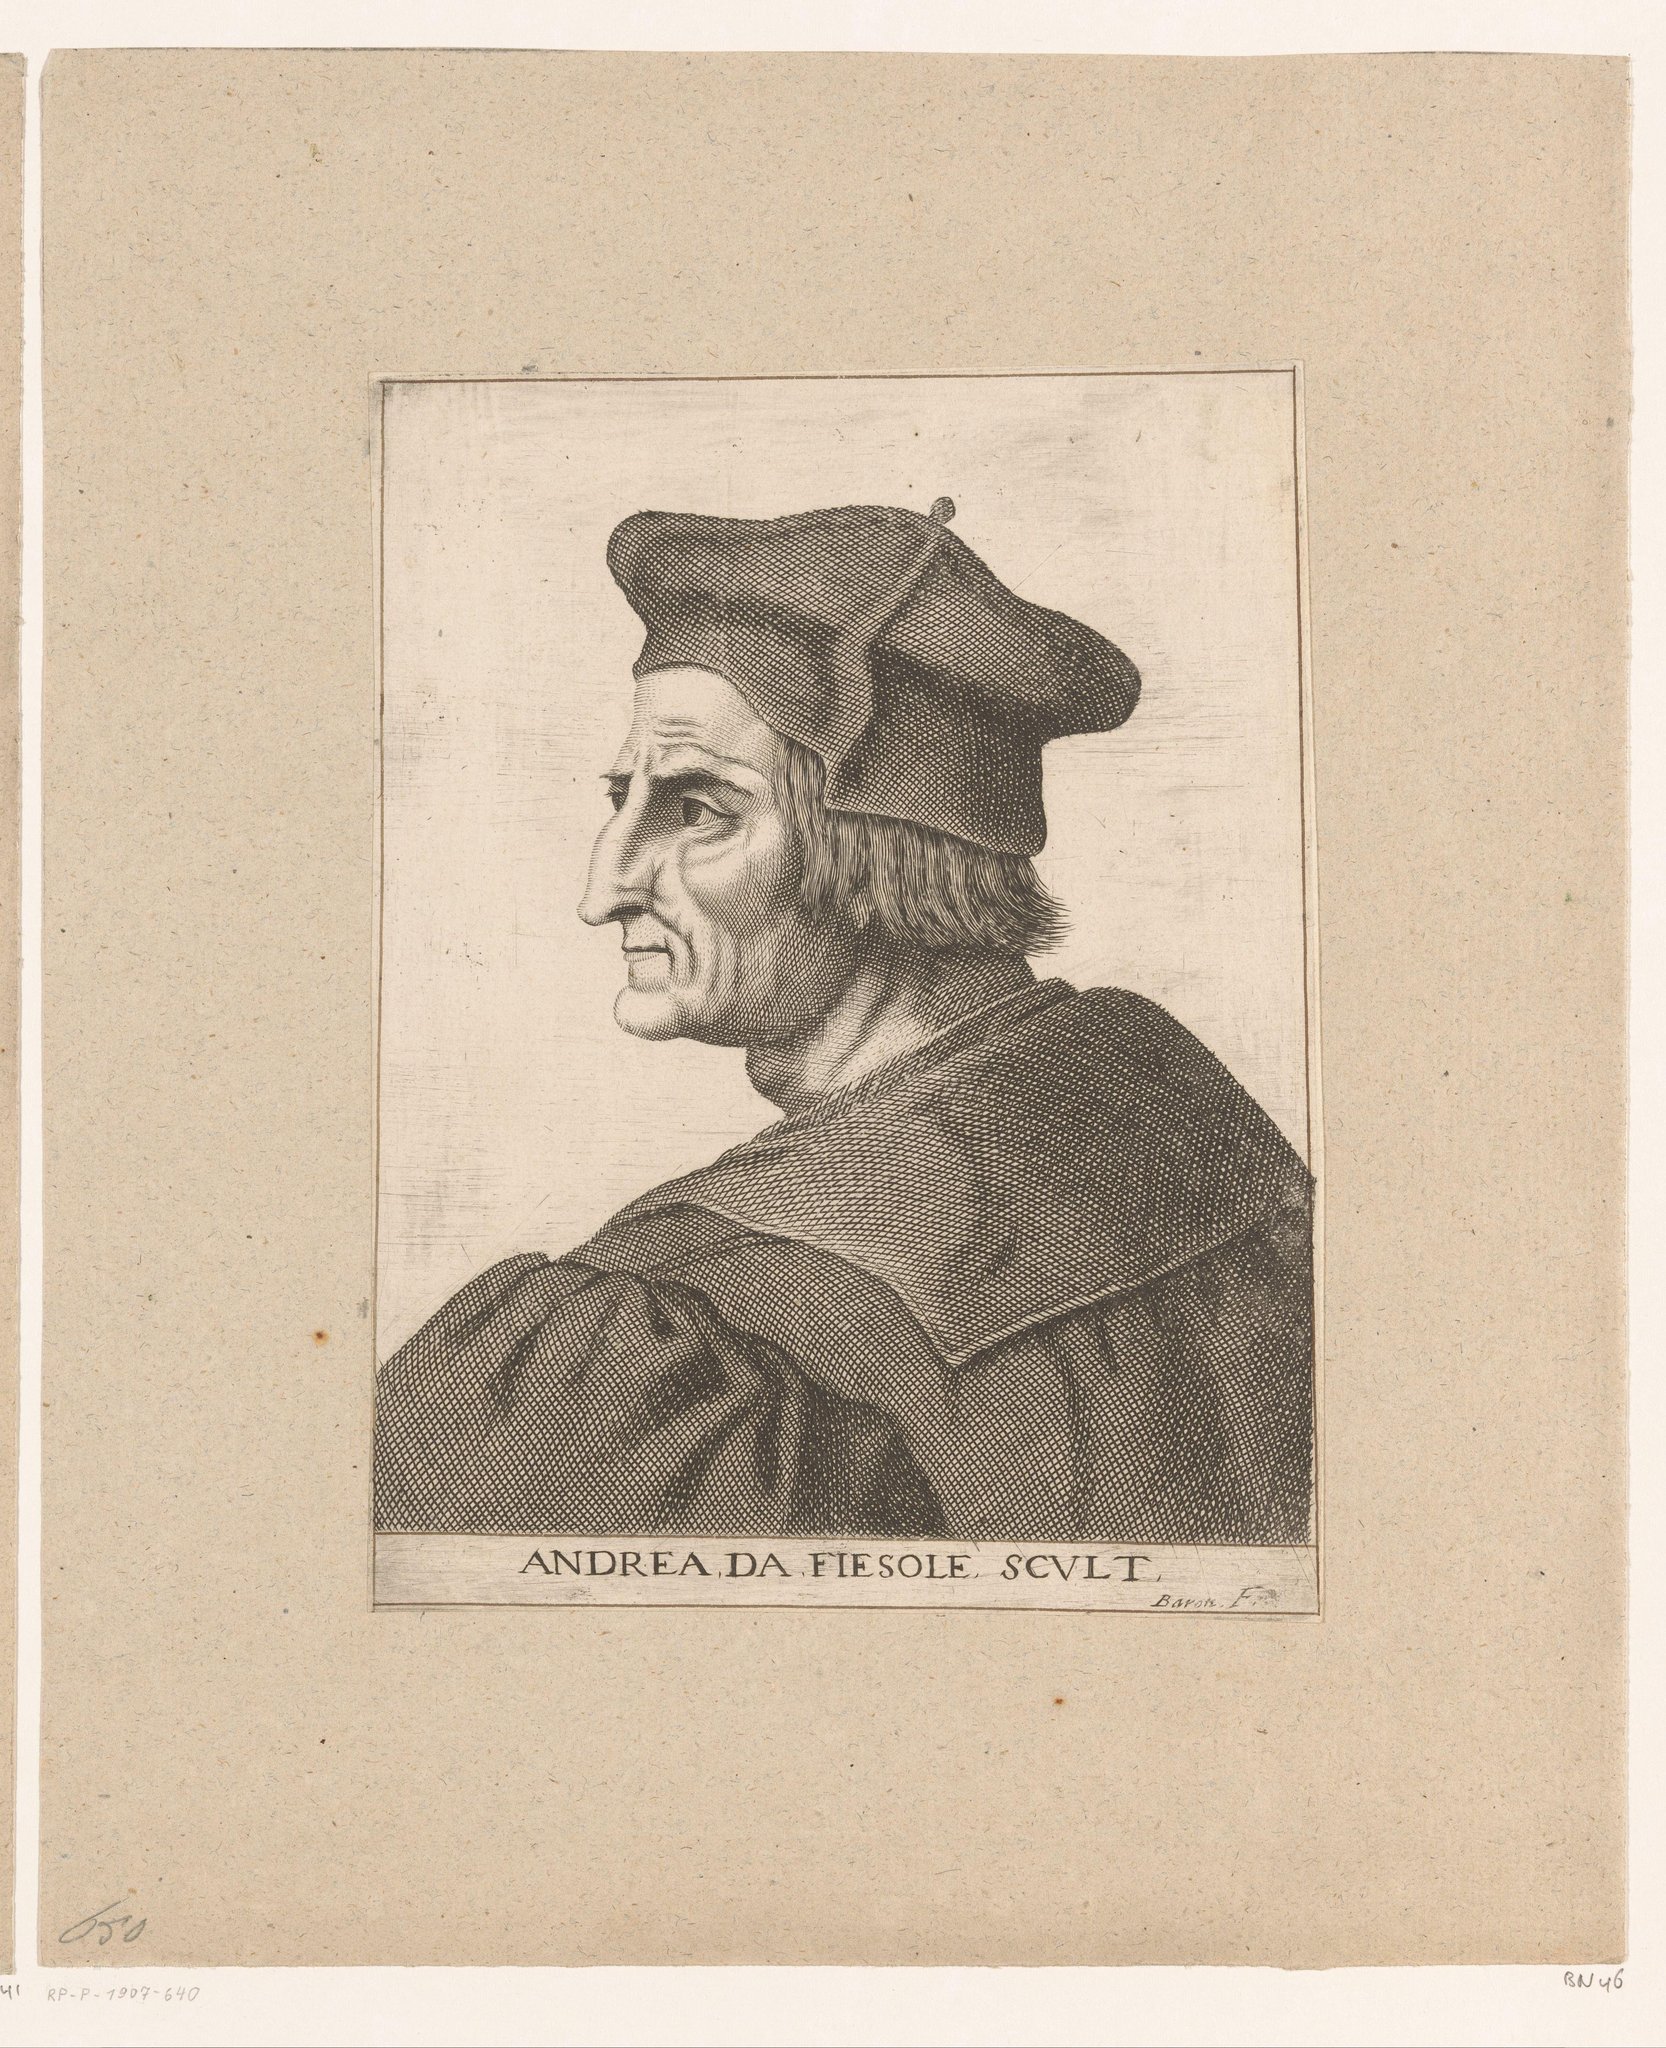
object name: print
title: Portret van Andrea Ferrucci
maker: jean baron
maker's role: print maker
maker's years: 1616-1655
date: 1641-1741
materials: paper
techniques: engraving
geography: france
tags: sculptor, andrea ferrucci, portrait, self-portrait of sculptor